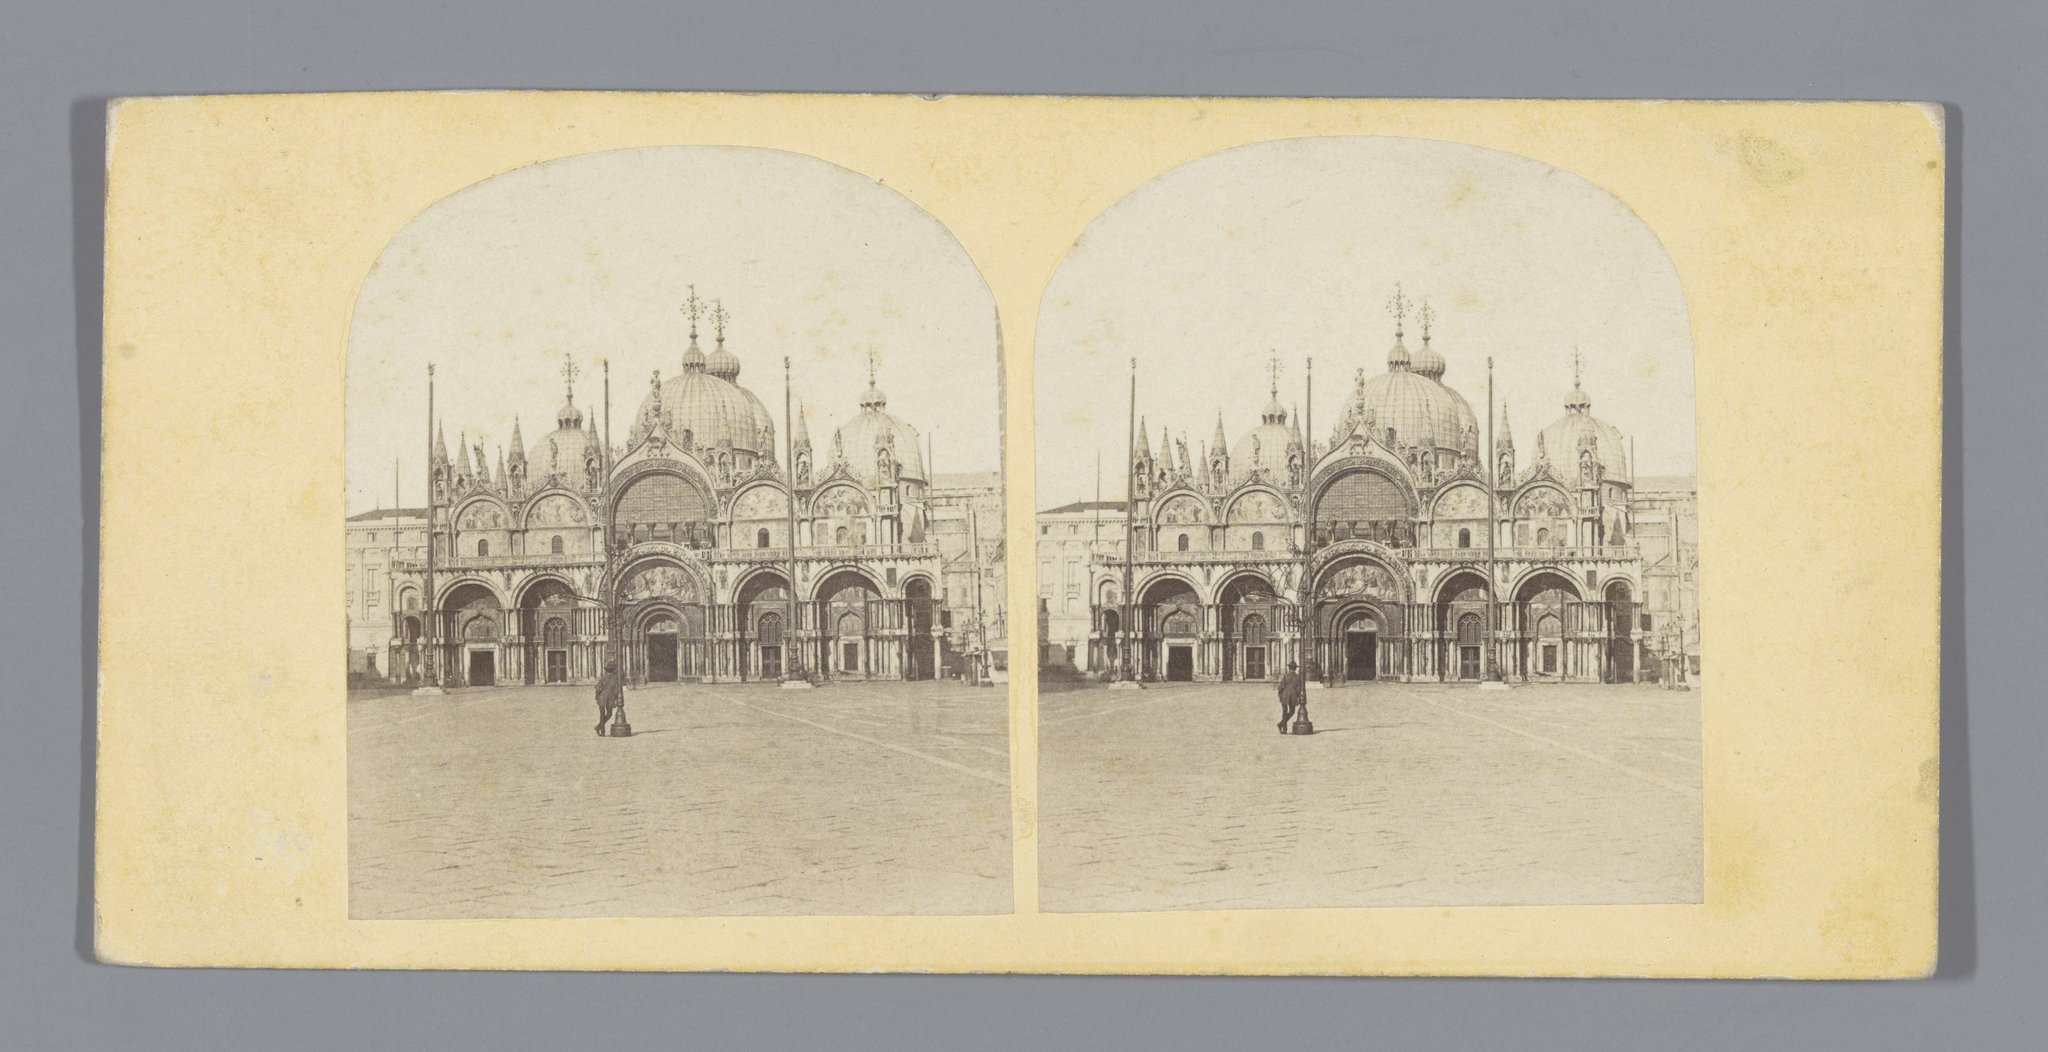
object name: stereograph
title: Voorgevel van de Basiliek van San Marco te Venetië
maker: Anonymous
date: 1870-1900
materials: cardboard, photographic support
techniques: albumen print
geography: san marco square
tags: church (exterior), façade (of house or building)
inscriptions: name: ‘Kunsthandlung von Joh. Heinrigs CÖLN. Hochstrasse 152.’, inscription: ‘St. Marco Venetië’